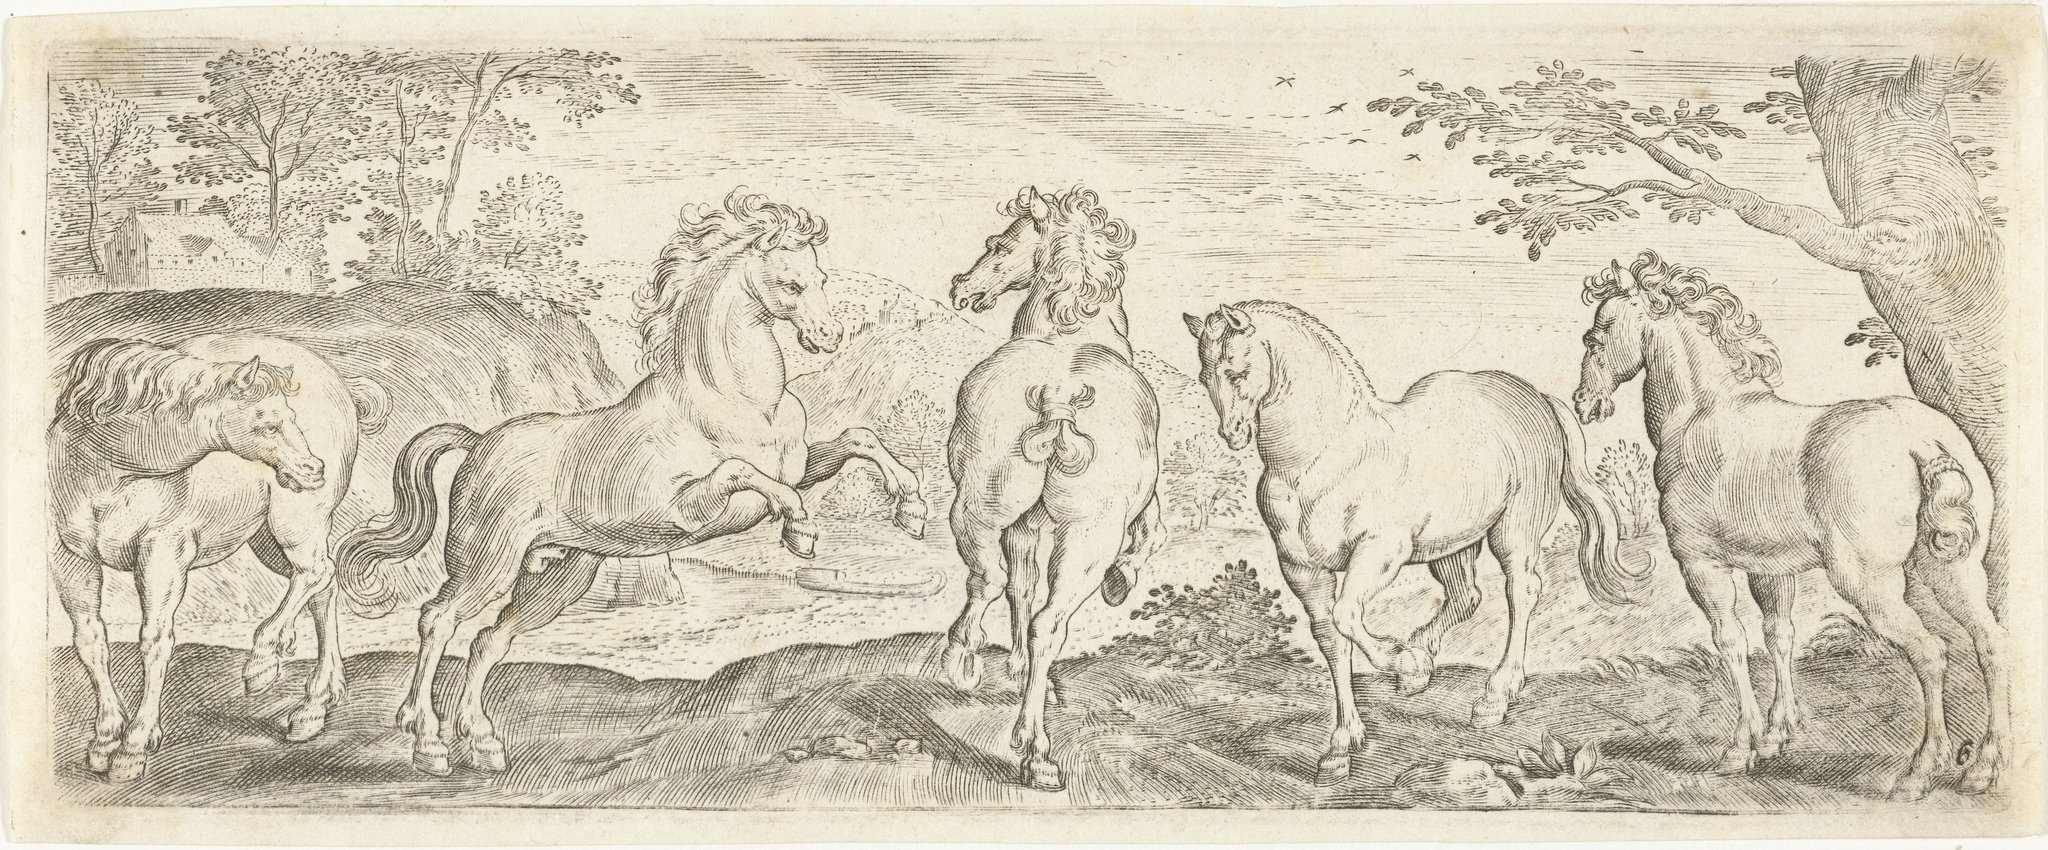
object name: print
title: Dieren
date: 1583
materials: paper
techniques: engraving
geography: bruges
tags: horse, horse in motion, farm or solitary house in landscape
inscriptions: collector's mark: Lugt 2228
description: Een verzameling van paarden. Van links naar rechts toont de prent 5 verschillende paarden in verschillende posities en profielen. (steigerend, in draf, van achter, etc.) Op de achtergrond een landschap en een boerderij.